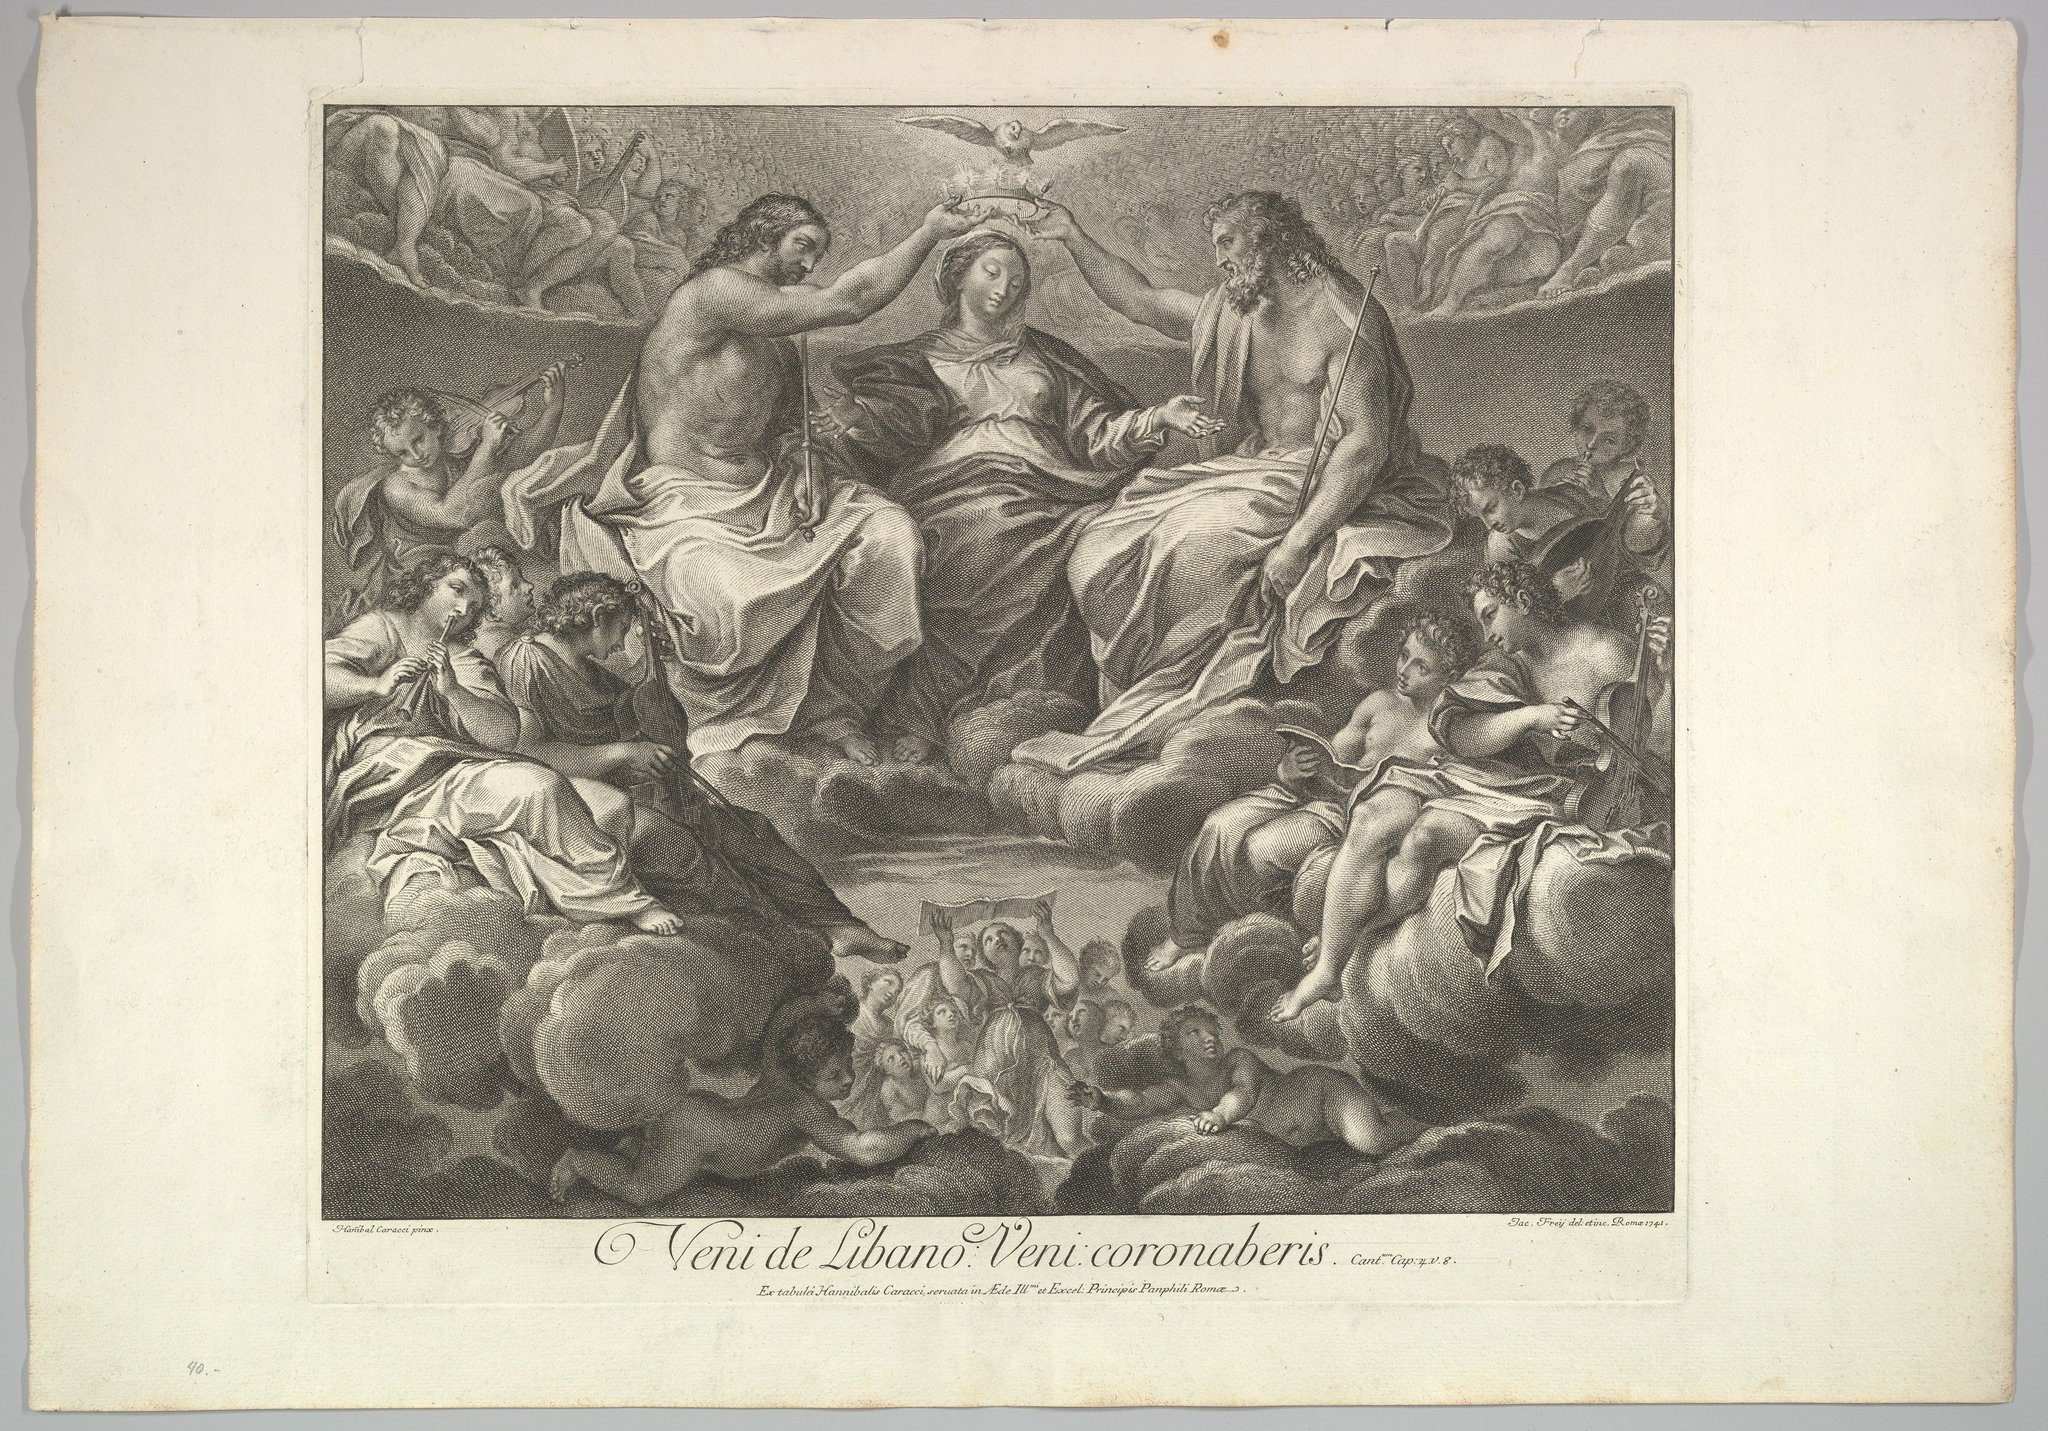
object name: print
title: Coronation of the Virgin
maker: annibale carracci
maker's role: artist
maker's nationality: italian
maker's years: 1560-1609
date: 1741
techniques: engraving, etching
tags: birds,men,women,virgin mary